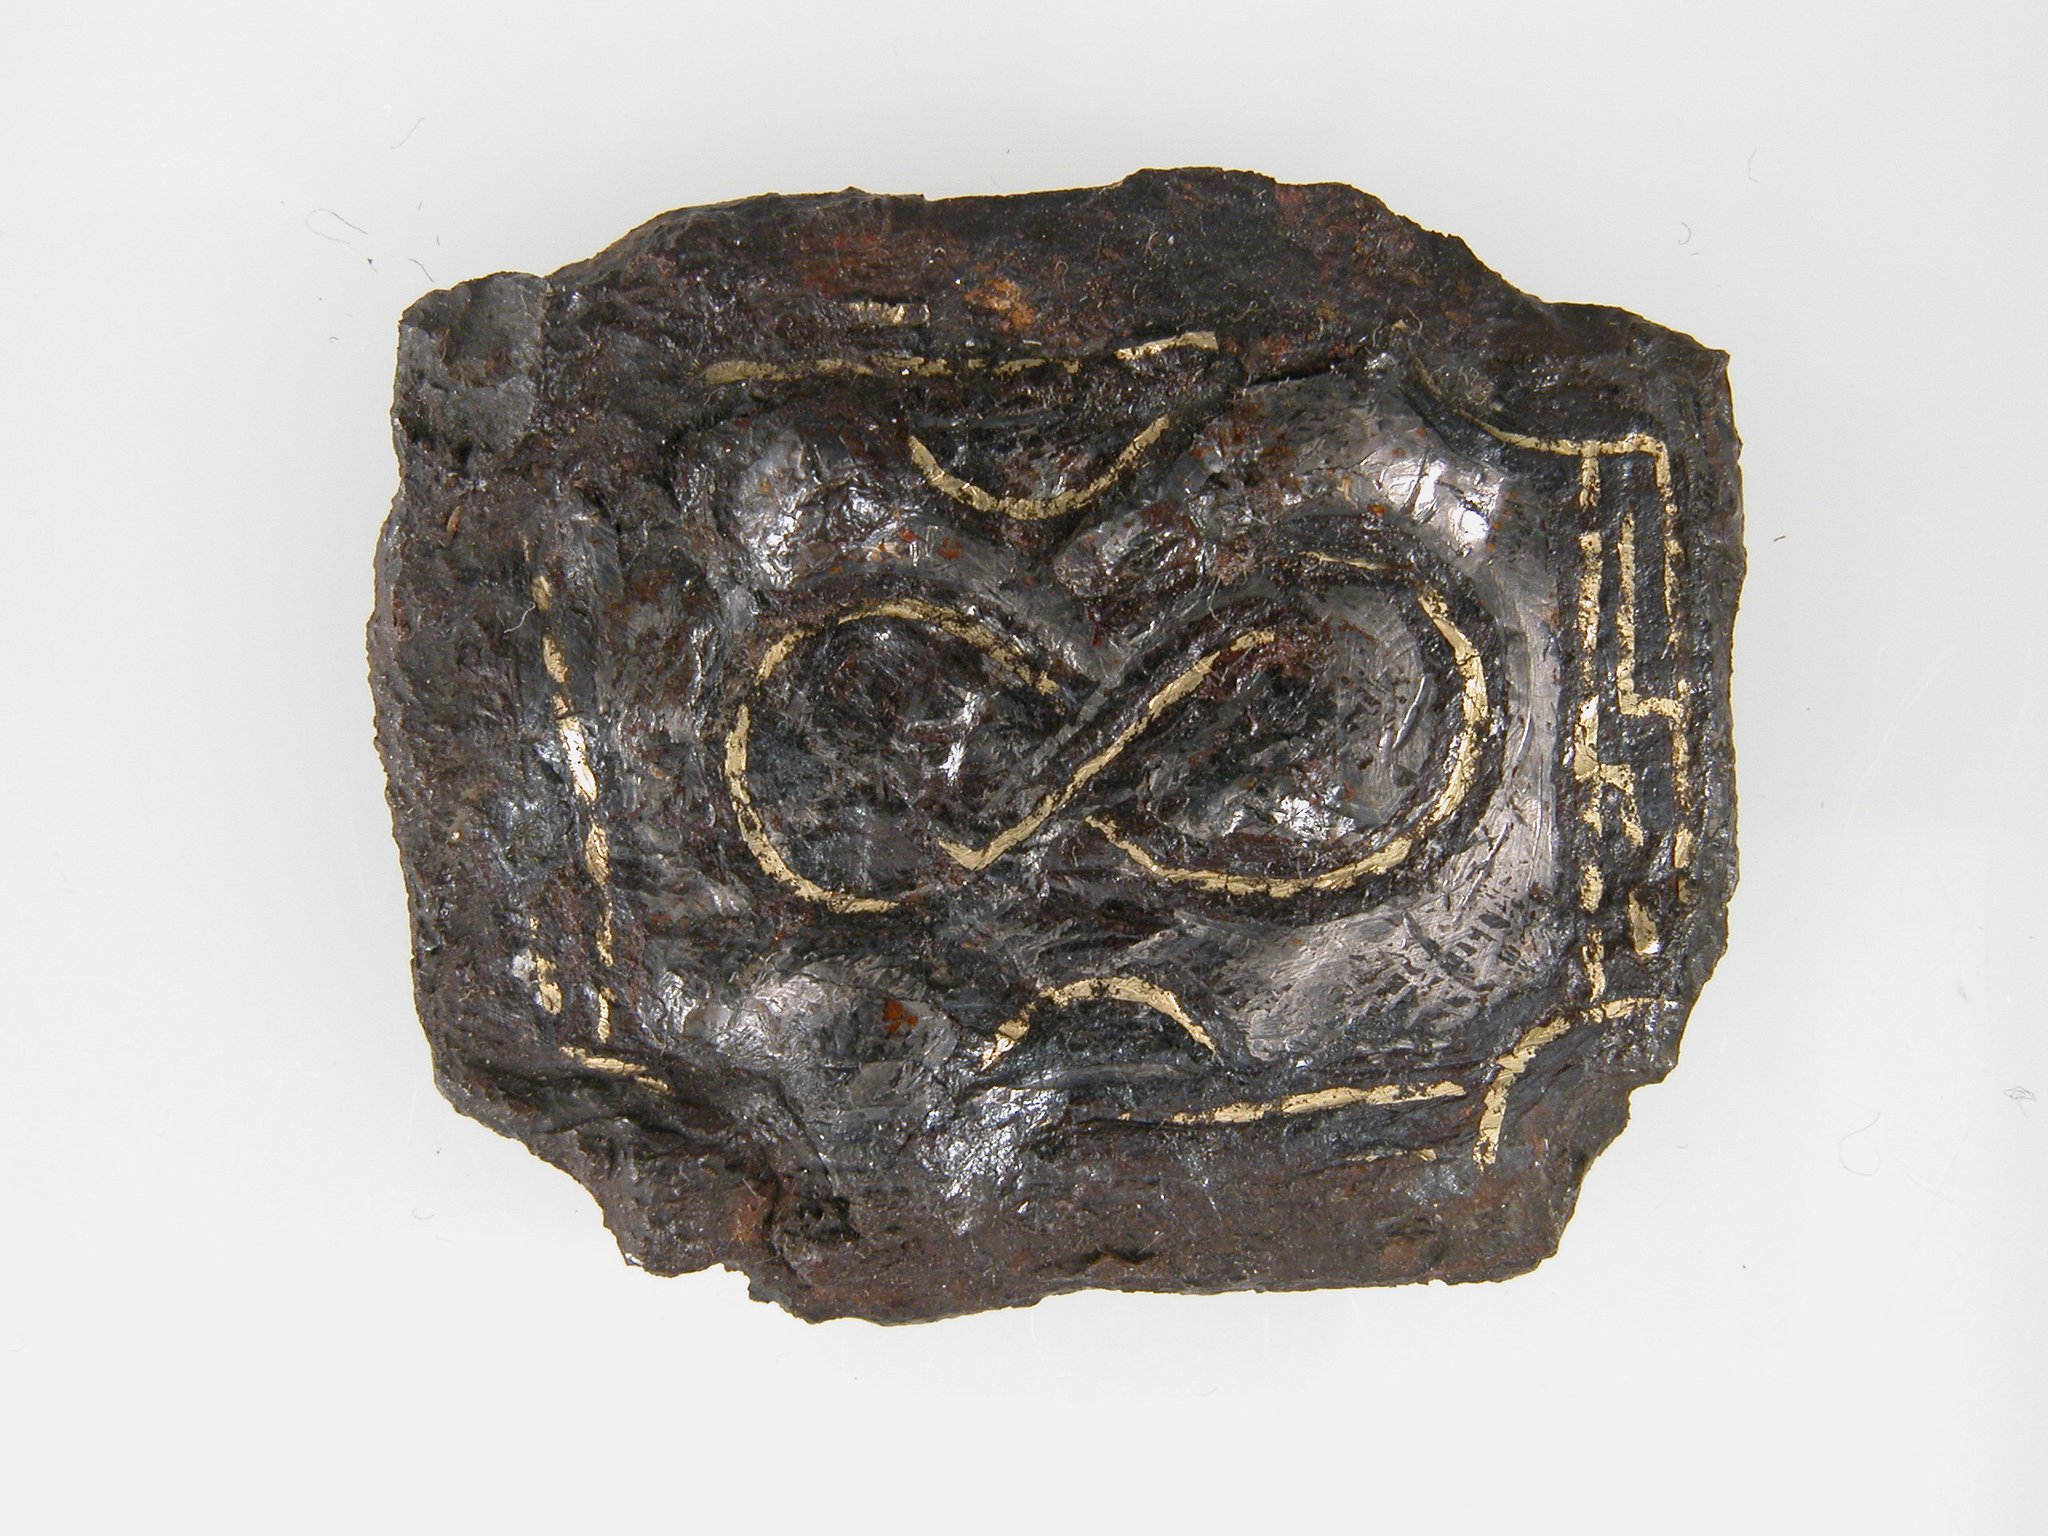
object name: belt plate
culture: frankish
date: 501-700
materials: brass, iron, silver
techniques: inlay